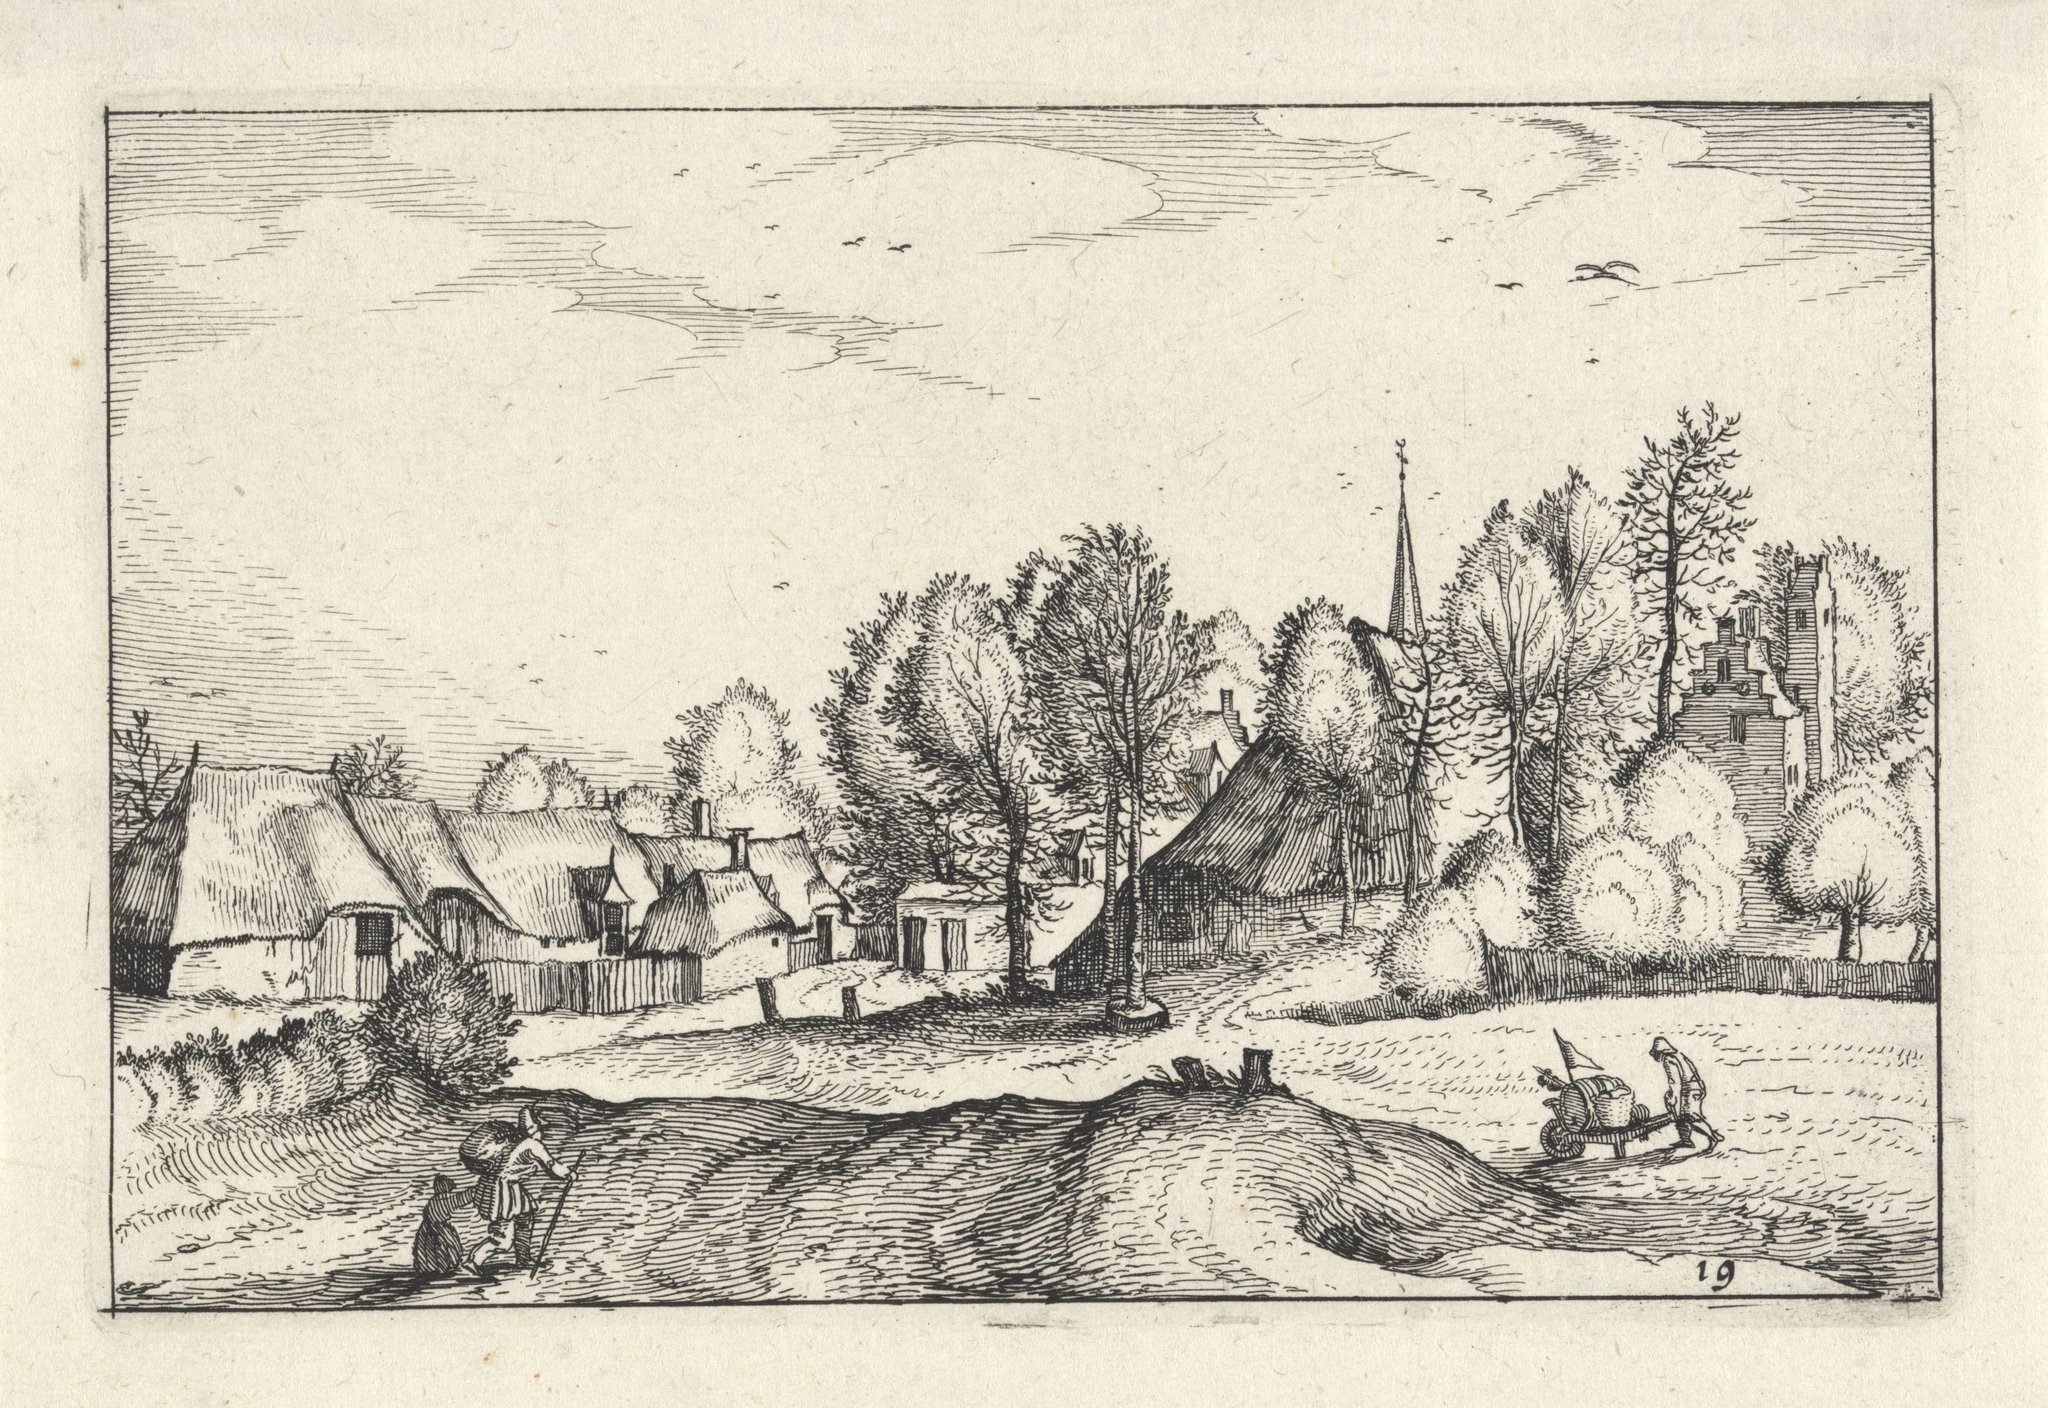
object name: print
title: Landschappen met gebouwen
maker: claes jansz. visscher (ii)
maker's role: draughtsman, print maker, publisher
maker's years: 1586-1652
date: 1620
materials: paper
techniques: etching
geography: amsterdam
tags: village, road, path, wheelbarrow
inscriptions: collector's mark: Lugt 240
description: Gezicht op een glooiend landschap met een kronkelende brede landweg die naar een dorp leidt. Over de weg loopt een man met een kruiwagen.